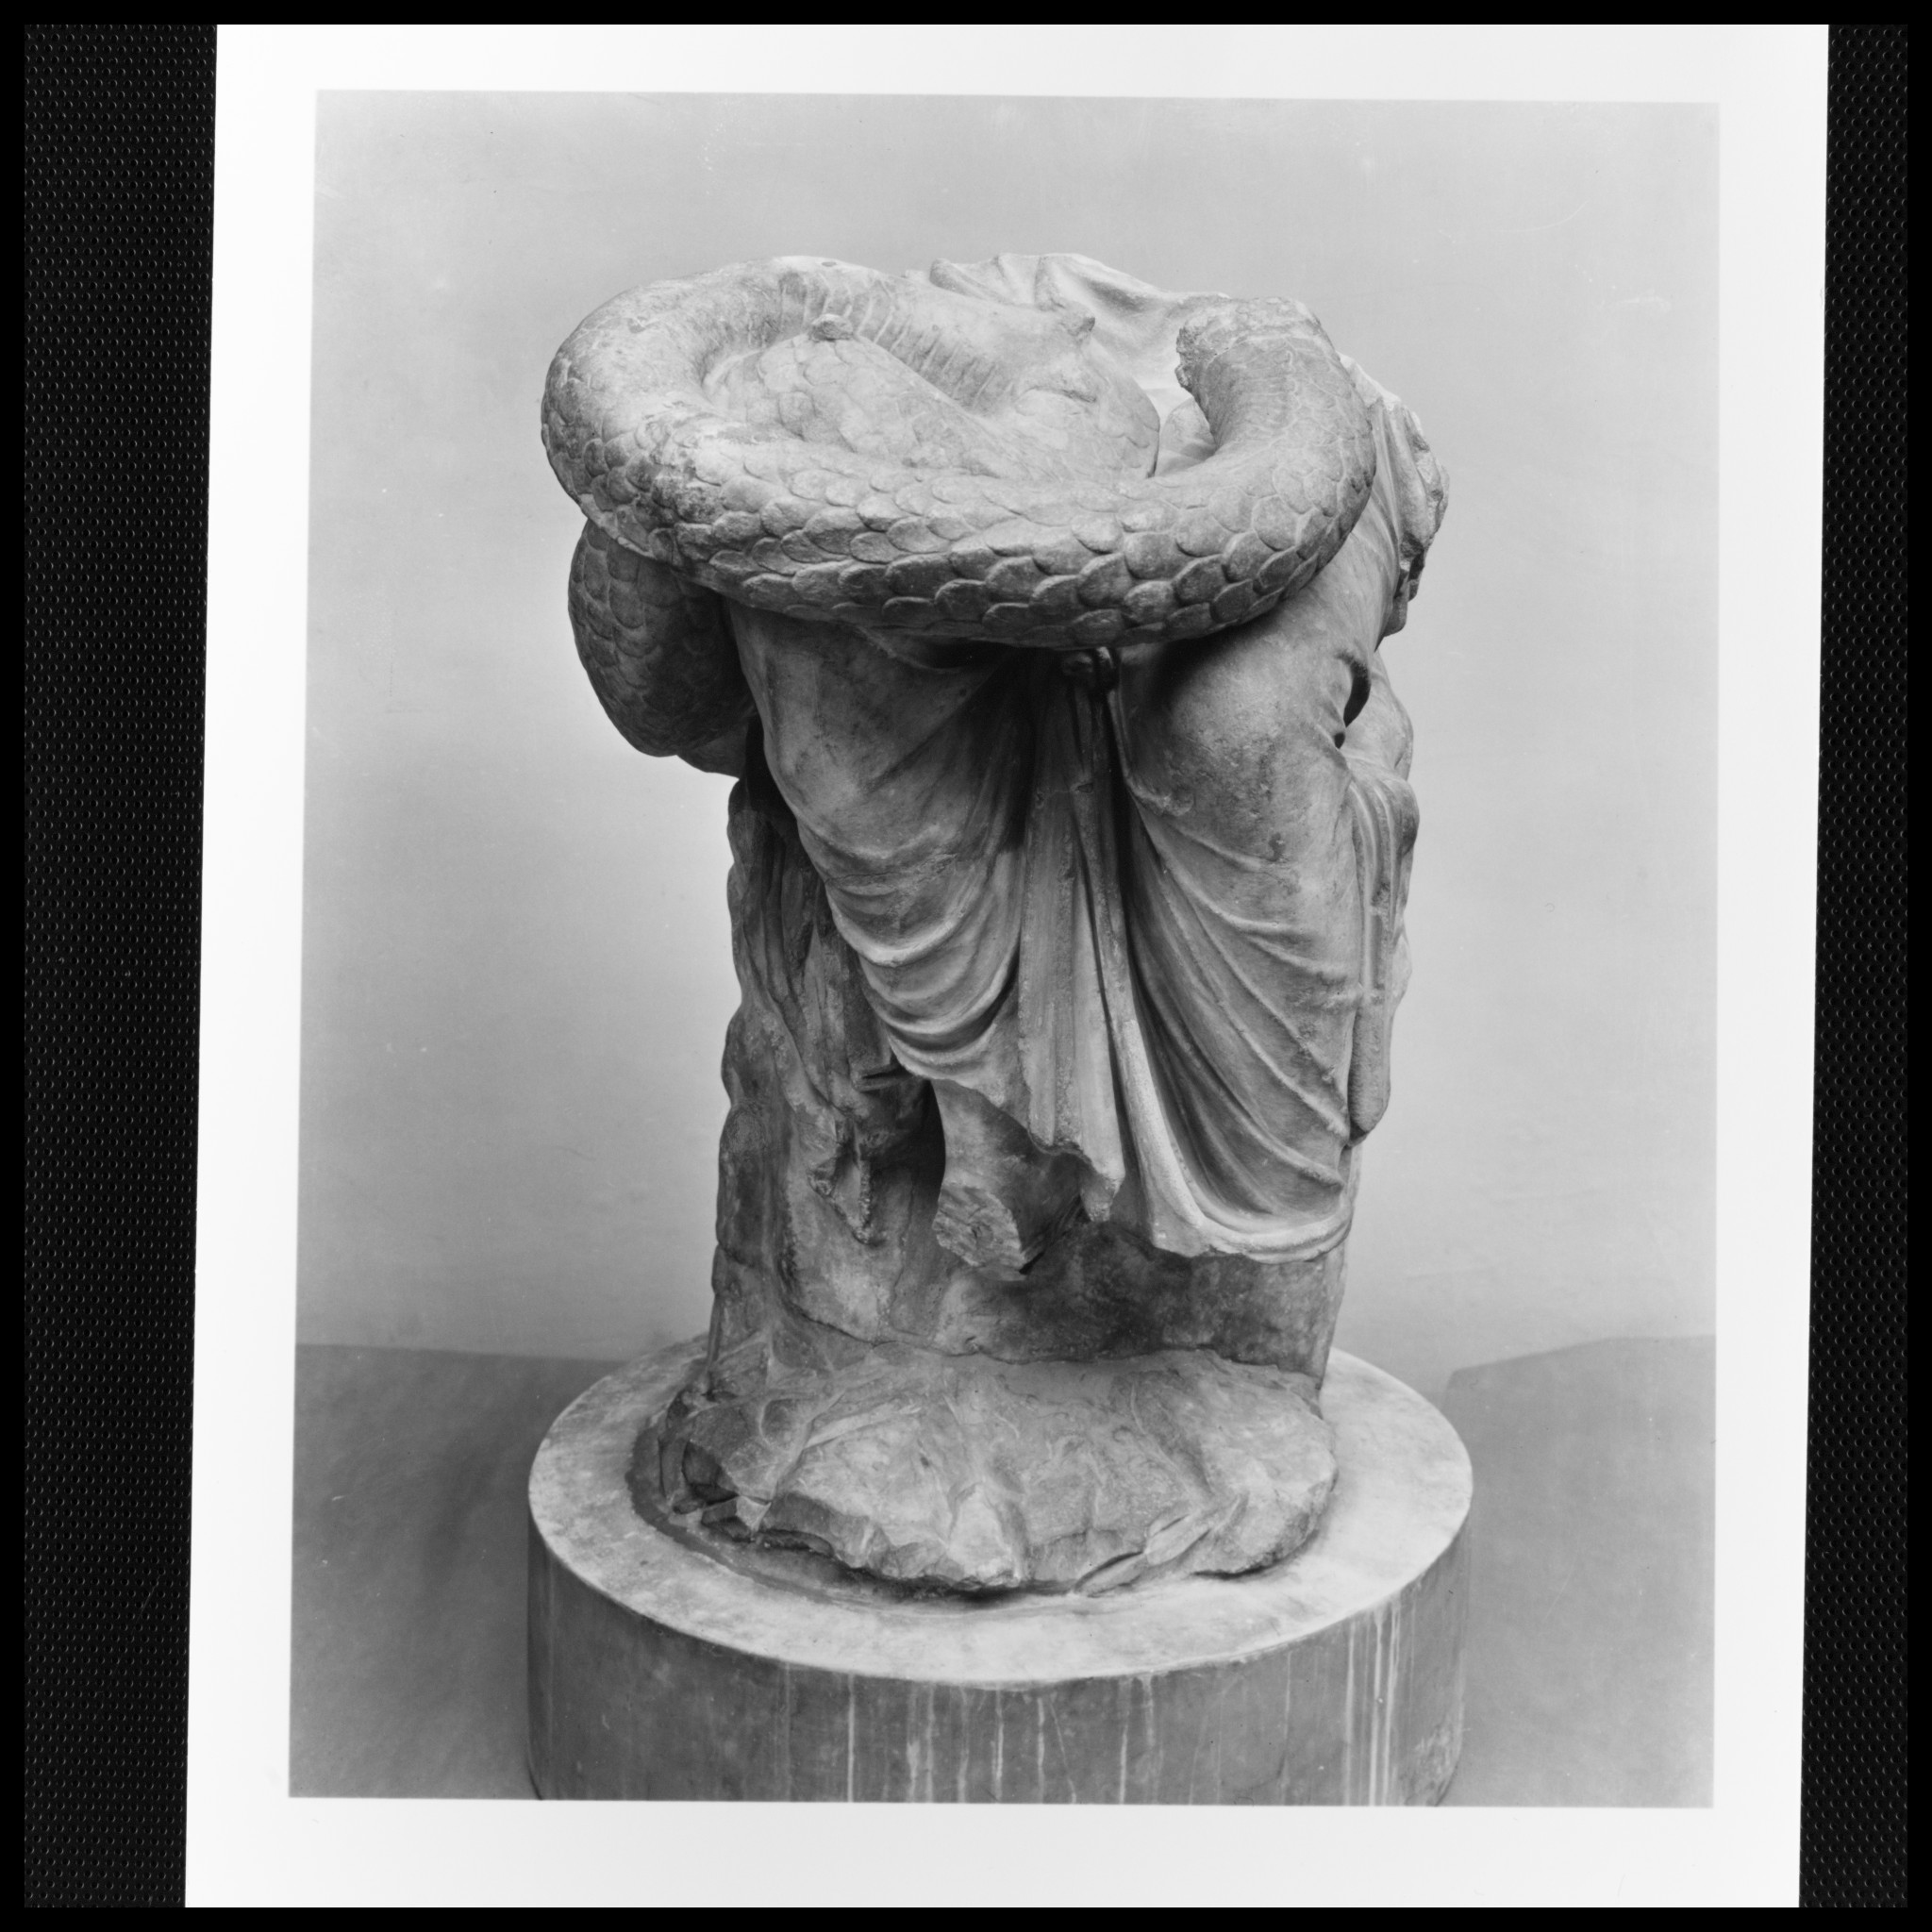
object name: statue of a woman, lower part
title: Lower part of a marble seated statue of Hygieia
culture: roman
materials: marble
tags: serpents